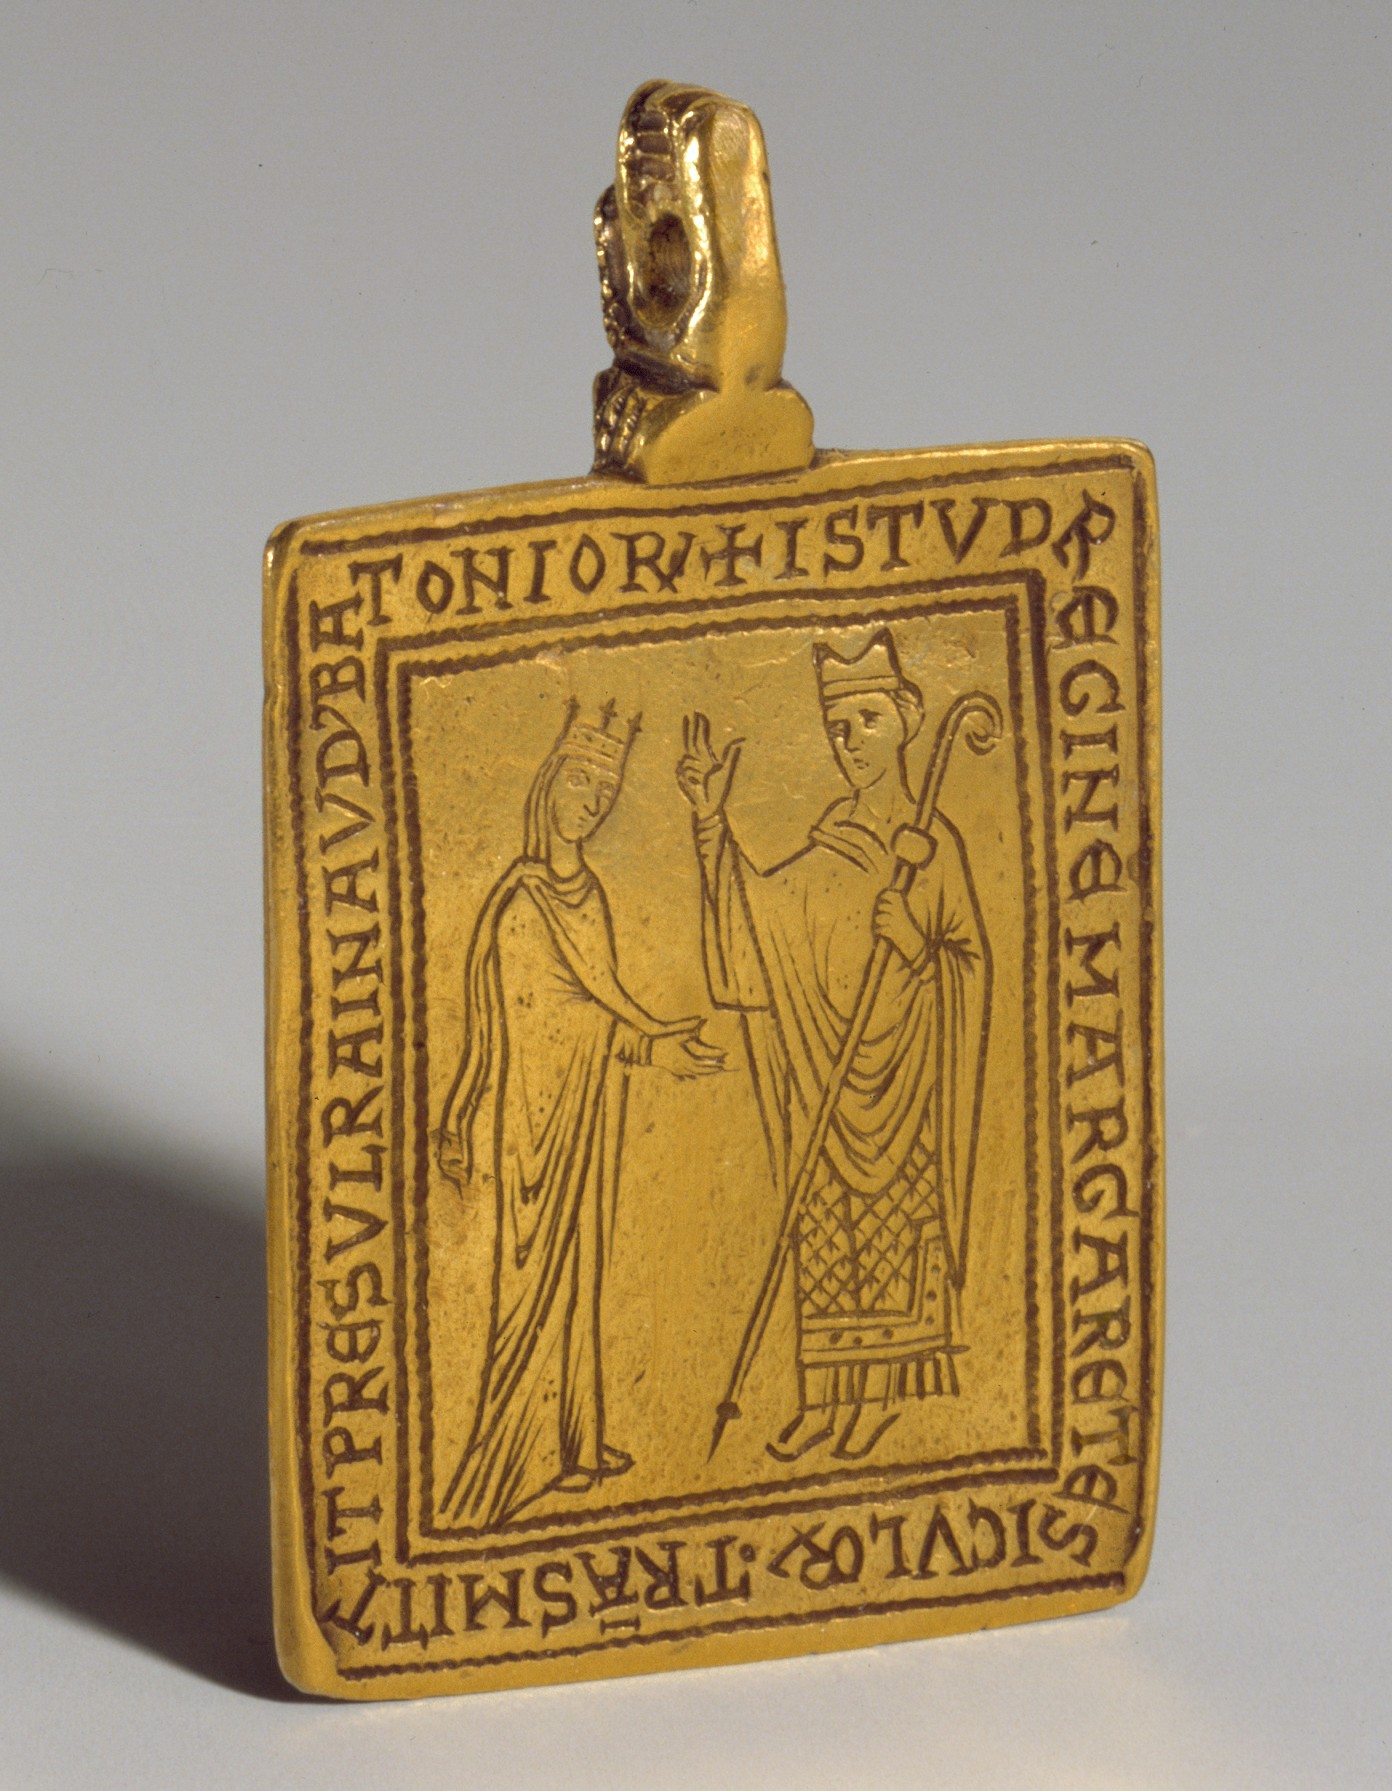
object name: reliquary pendant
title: Reliquary Pendant with Queen Margaret of Sicily Blessed by Bishop Reginald of Bath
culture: british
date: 1174-1177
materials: gold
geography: england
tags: queens,men,women,bishops